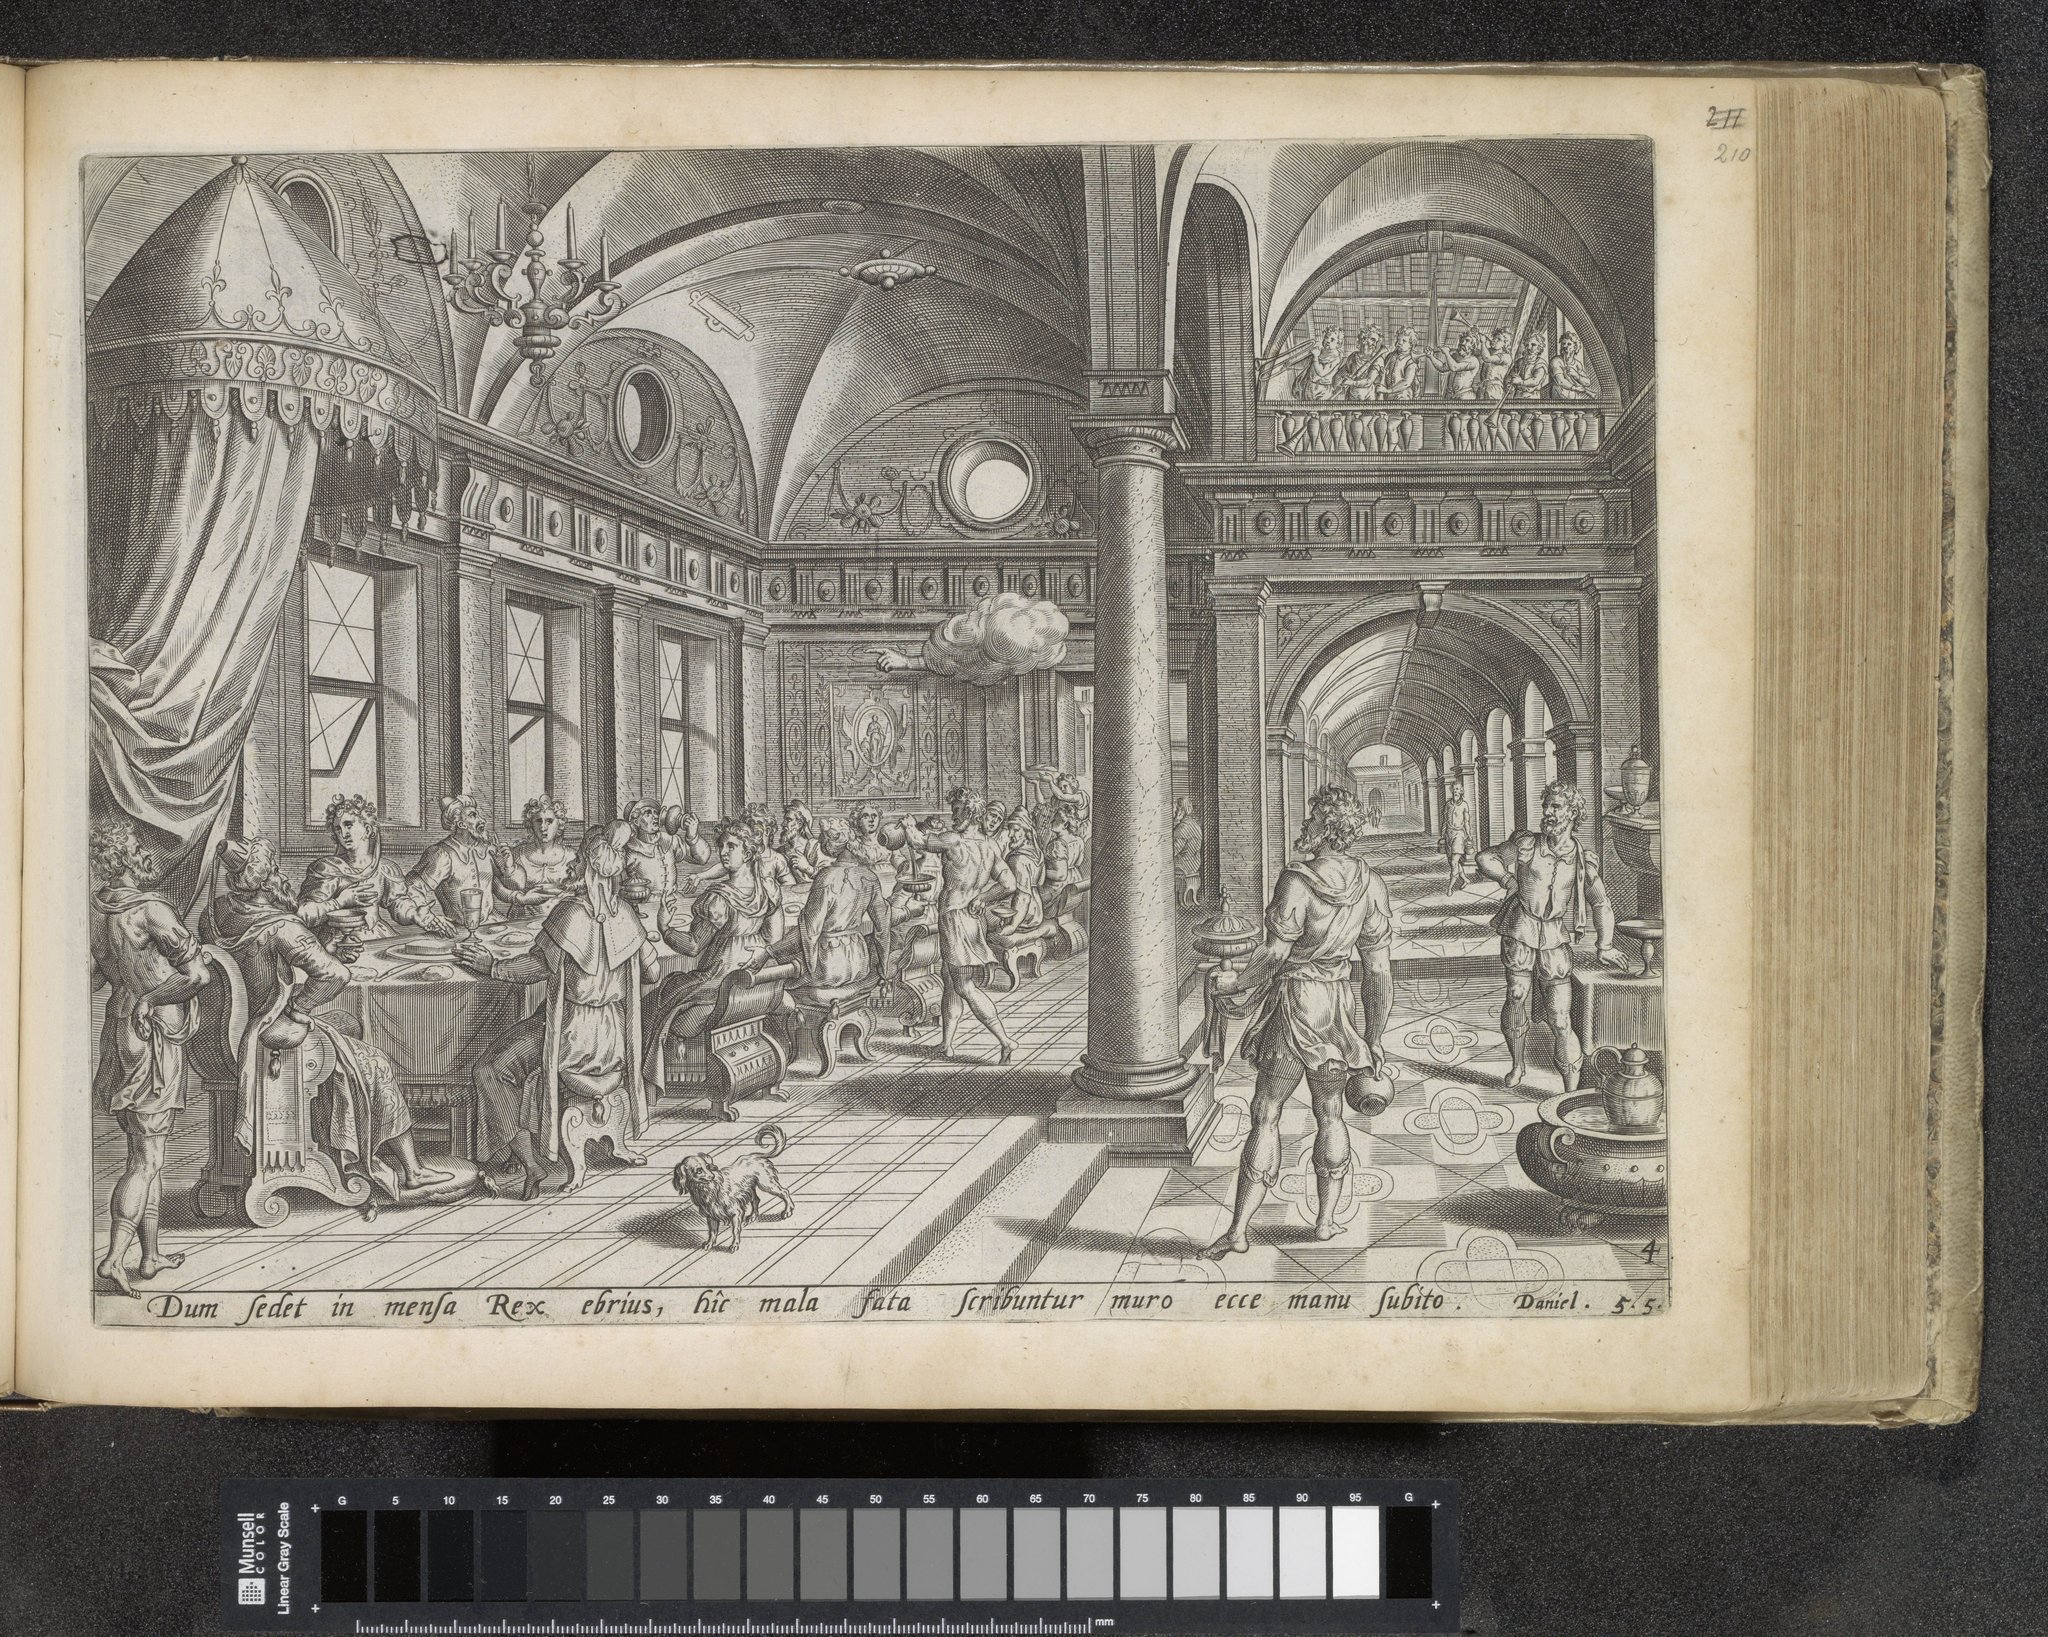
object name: album leaf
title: Feestmaal van Belsassar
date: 1643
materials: paper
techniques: engraving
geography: amsterdam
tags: during belshazzar's banquet a hand appears and writes on the wall (mene, mene, tekel and parsin (upharsin)); king belshazzar is frightened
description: Het feestmaal van Belsassar, koning van Babylon, met zijn hovelingen en vrouwen. Belsassar, op de rug gezien aan het hoofd van de tafel, ziet een schrijvende hand verschijnen. Op tafel staan de gestolen bekers en schalen uit de tempel van Jeruzalem. Rechtsboven staan trompetters op het balkon. Onder de voorstelling een verwijzing in het Latijn naar de Bijbeltekst in Dan. 5:5. Deze prent maakt deel uit van een album.